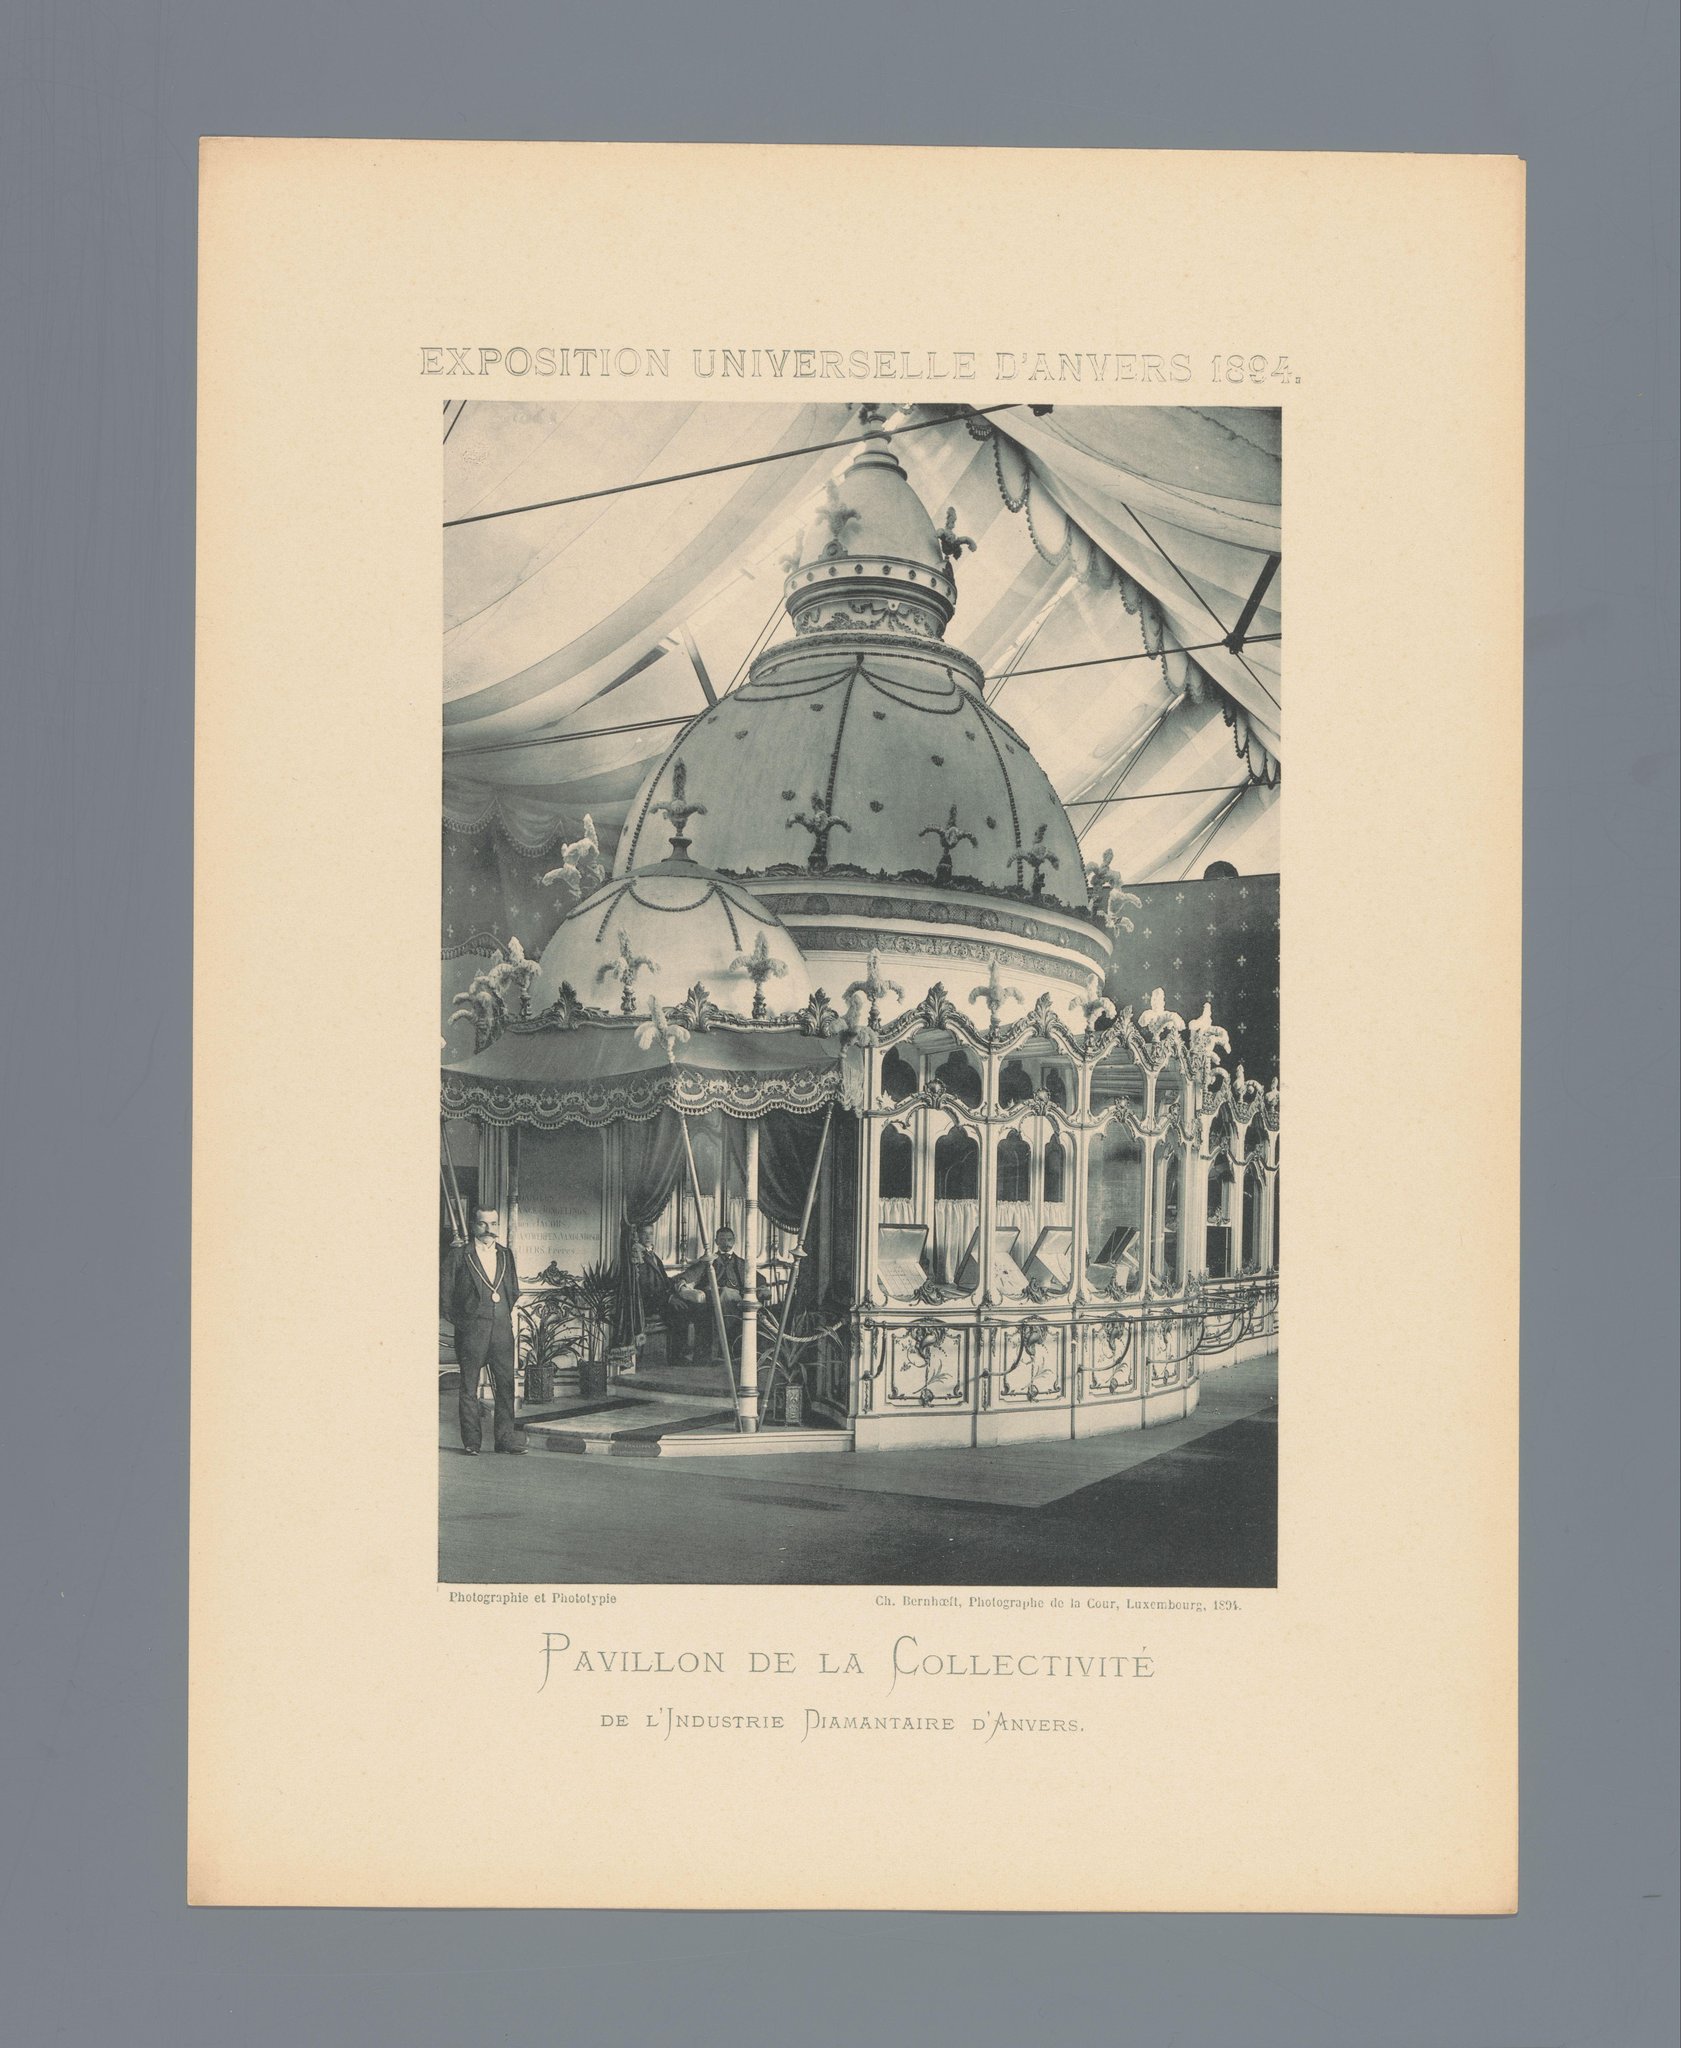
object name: photomechanical print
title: Pavillon de la Collectivité de l'Industrie Diamante d'Anvers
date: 1894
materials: paper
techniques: photograph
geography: luxembourg city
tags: world fair, world exhibition, historical persons, antwerp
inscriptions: inscription: ‘Exposition Universelle D'Anvers 1894’